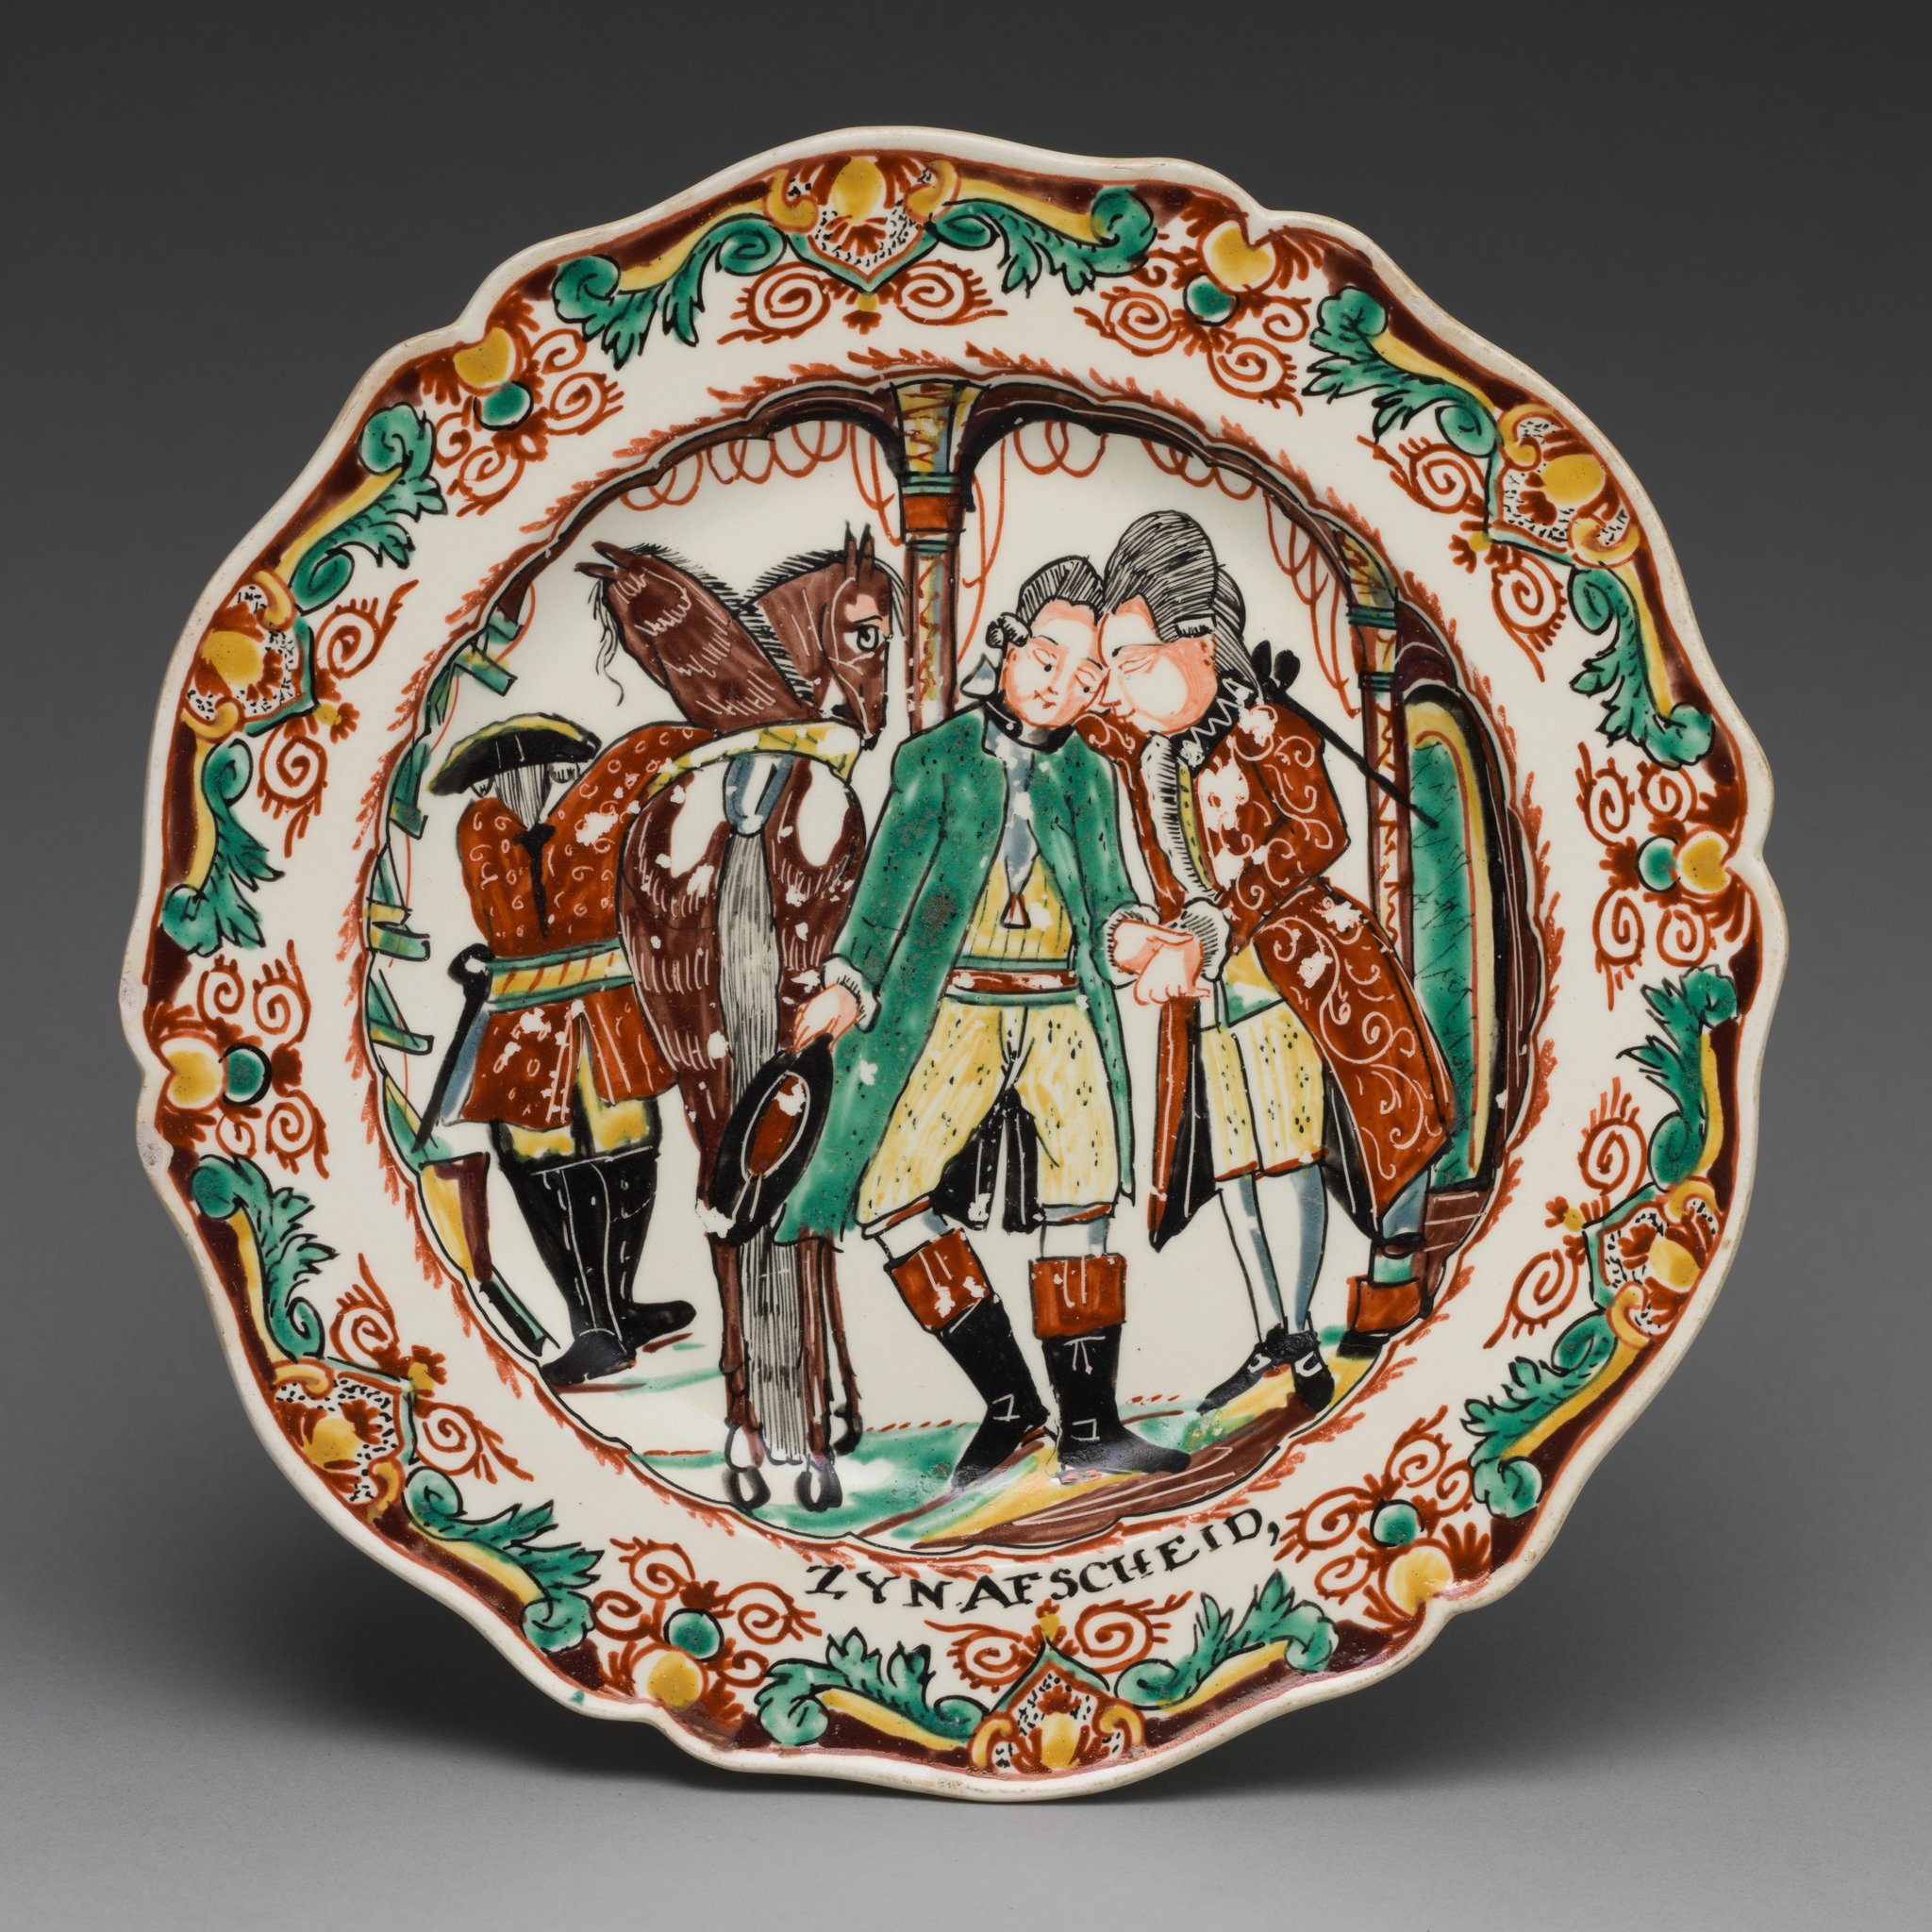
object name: plate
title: Plate (part of a set of six)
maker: john turner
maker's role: maker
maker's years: 1762-1786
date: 1790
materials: earthenware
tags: men,horses